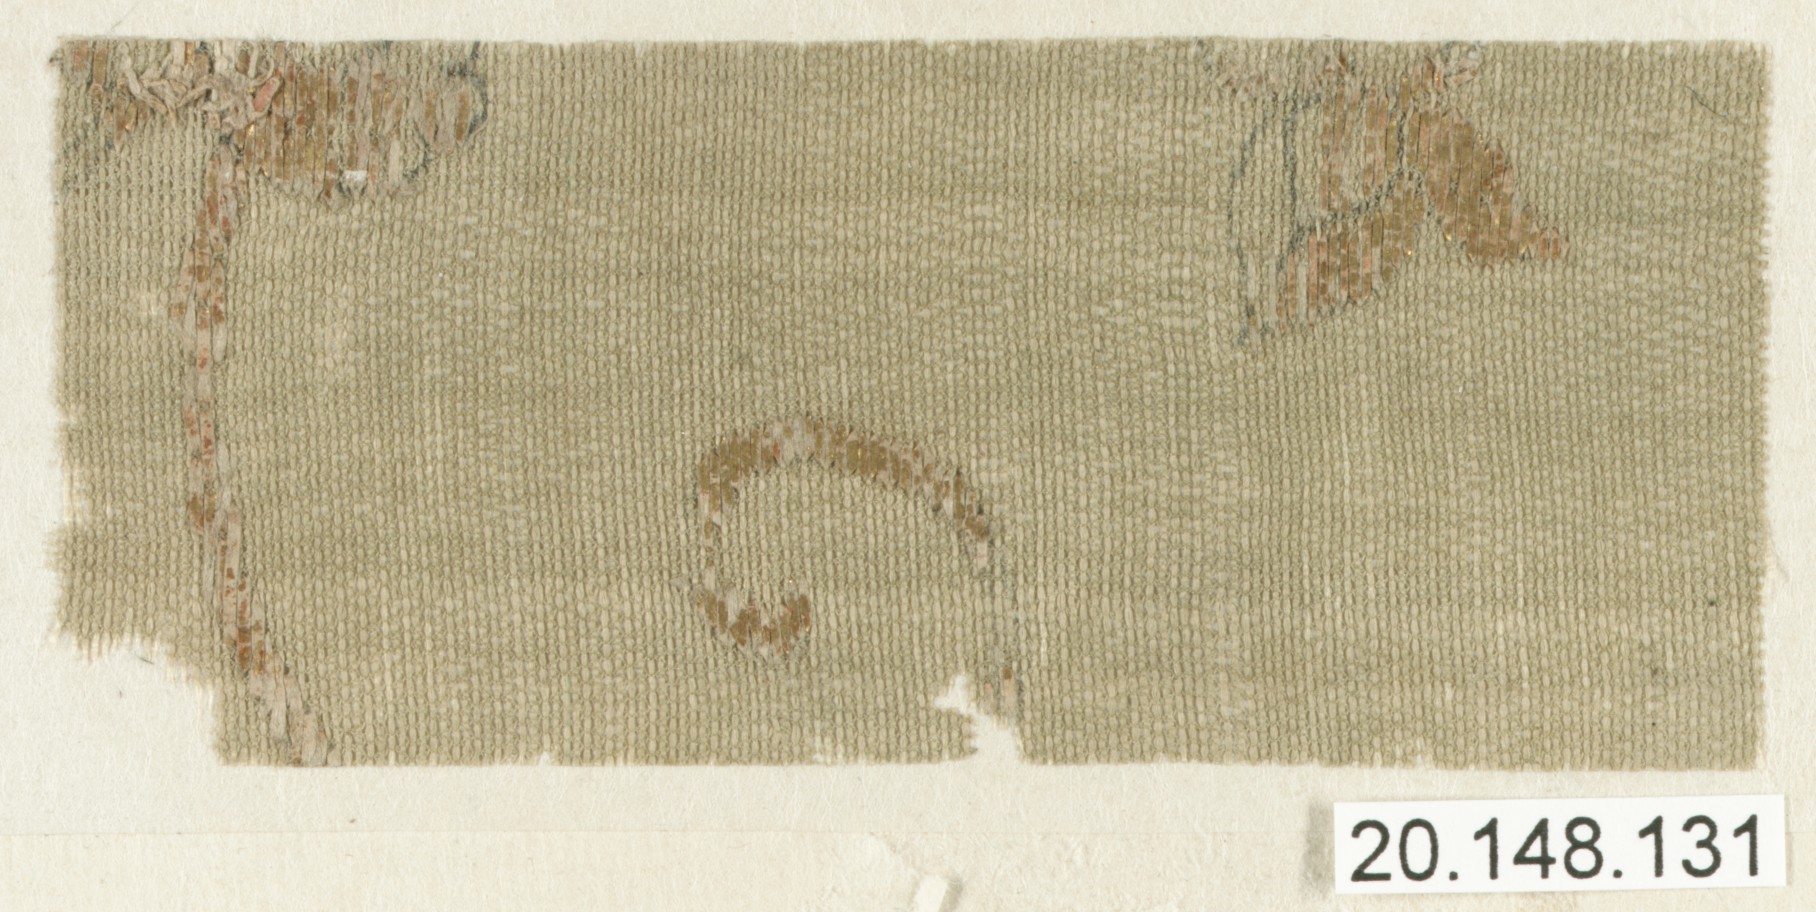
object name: textile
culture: chinese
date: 1501-1600